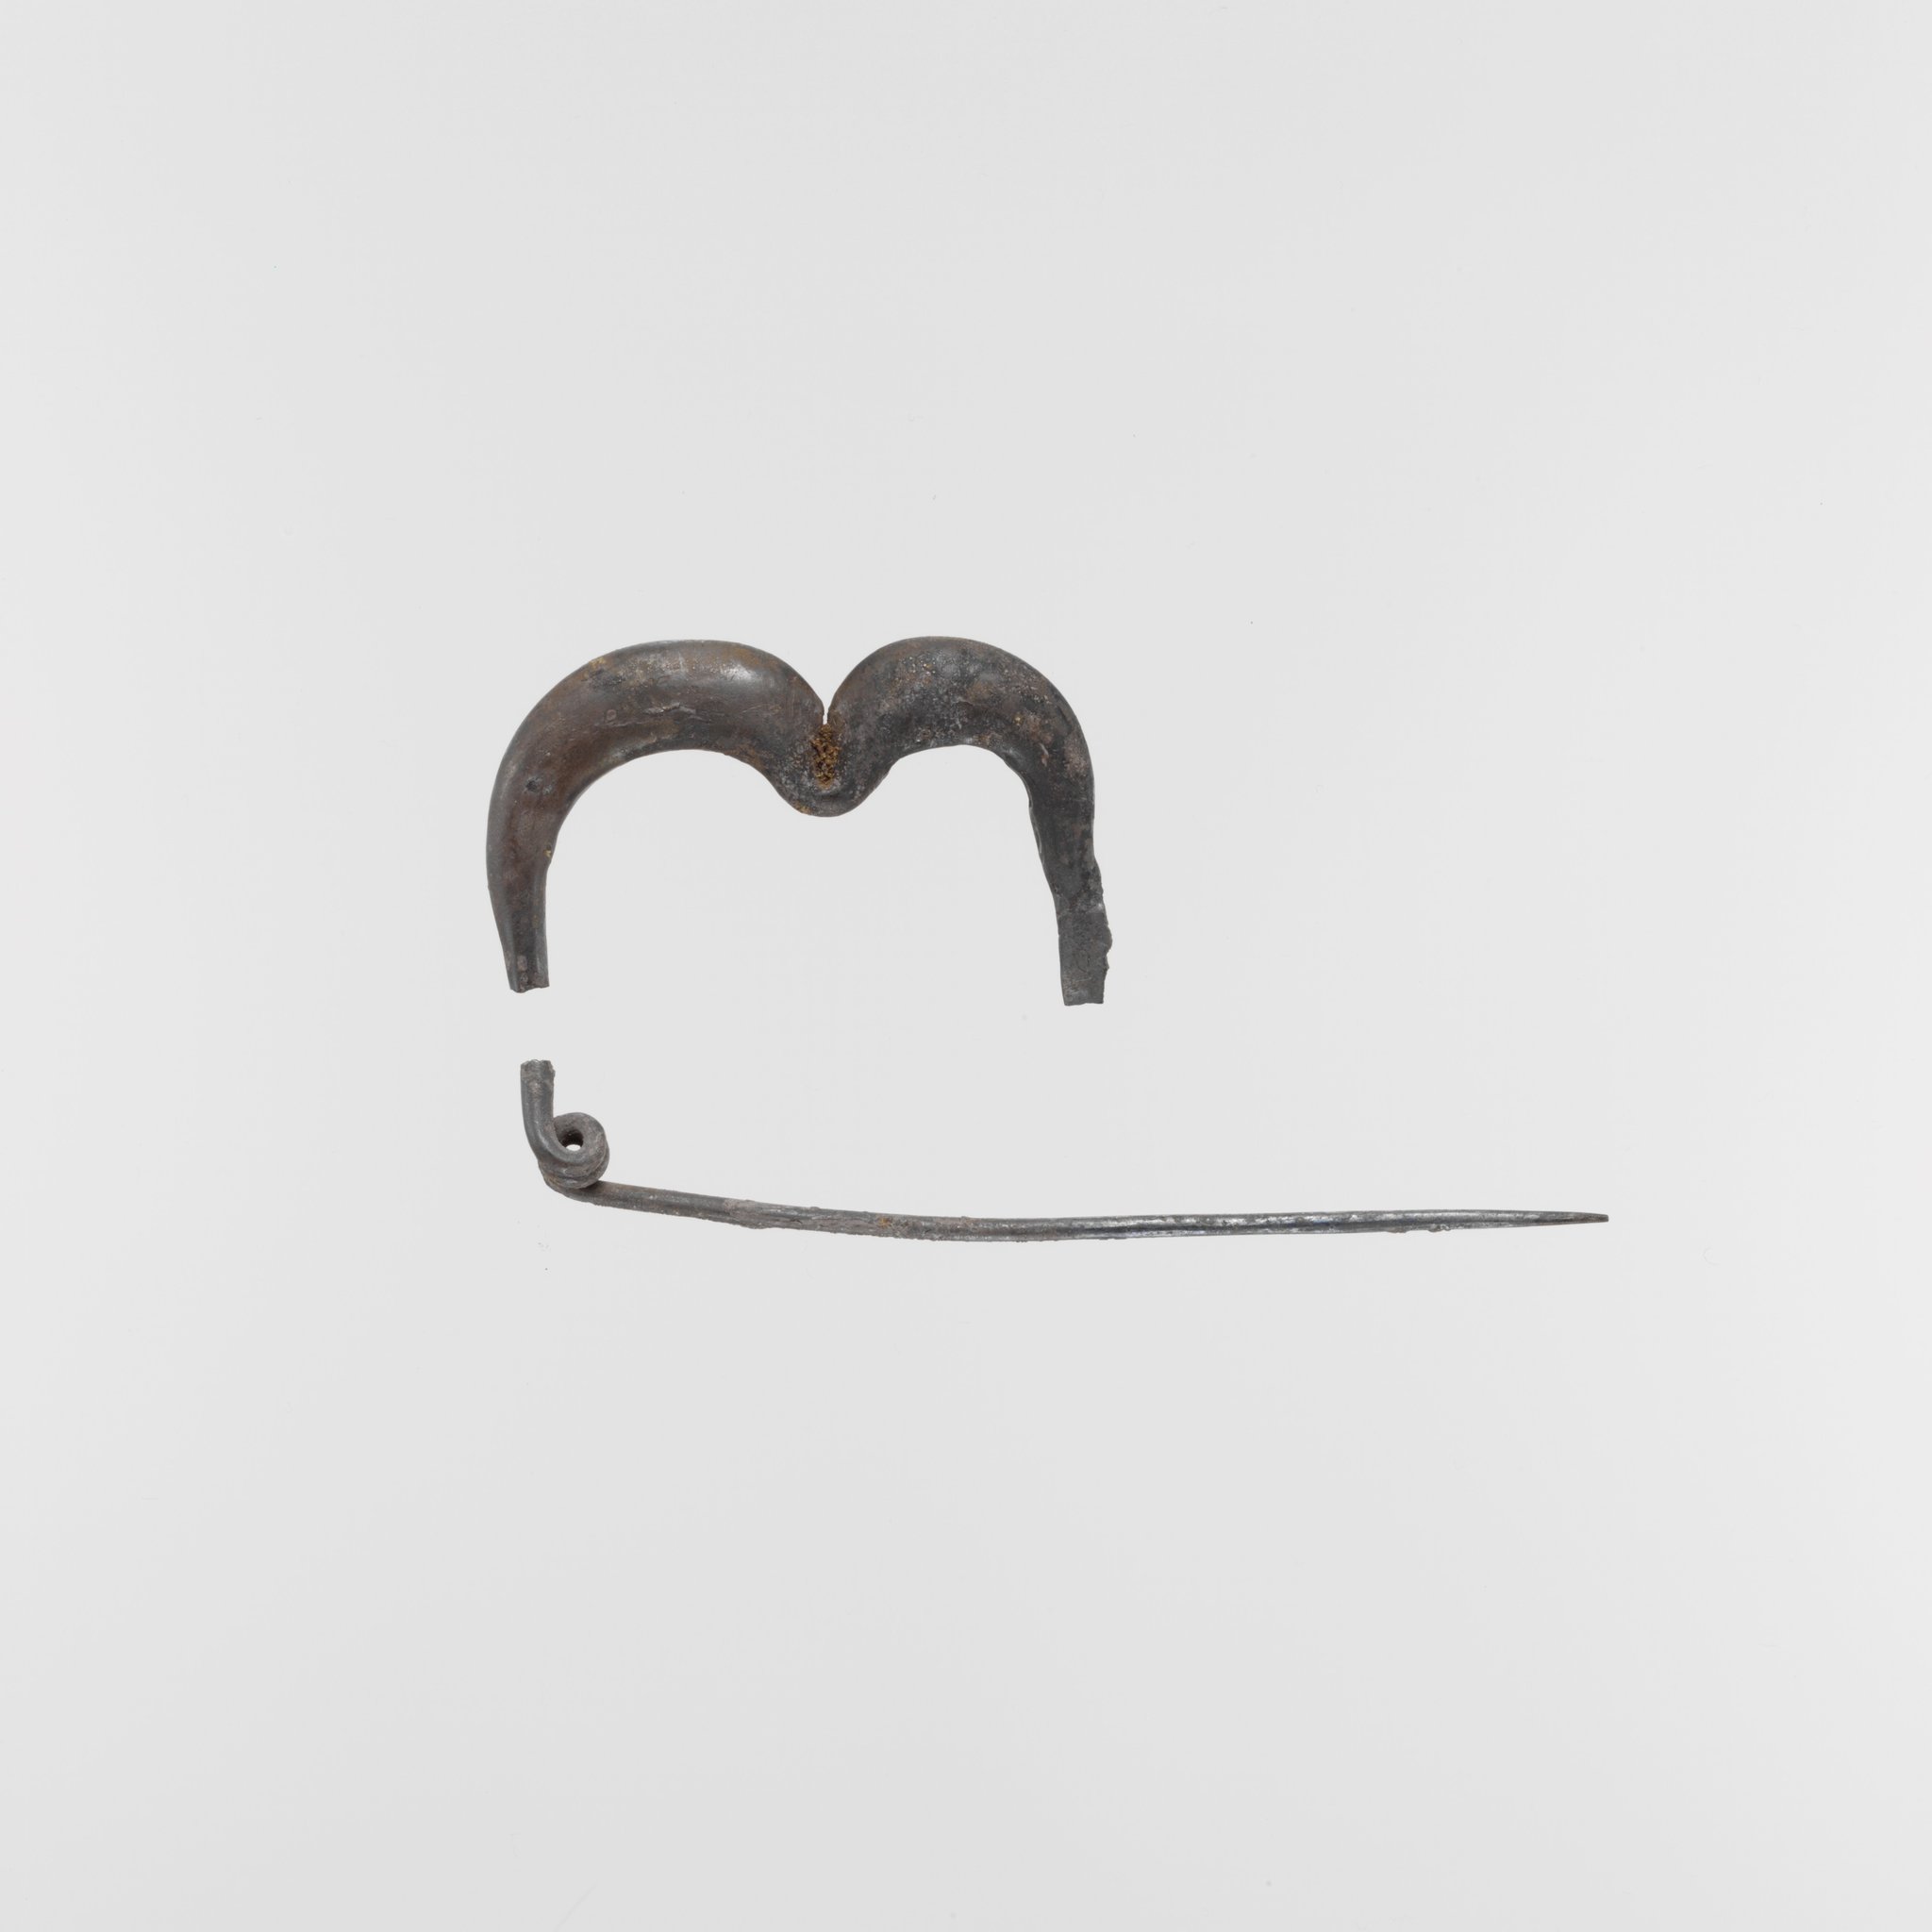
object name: fibula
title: Silver fibula (safety pin)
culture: greek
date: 400-301 BCE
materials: silver